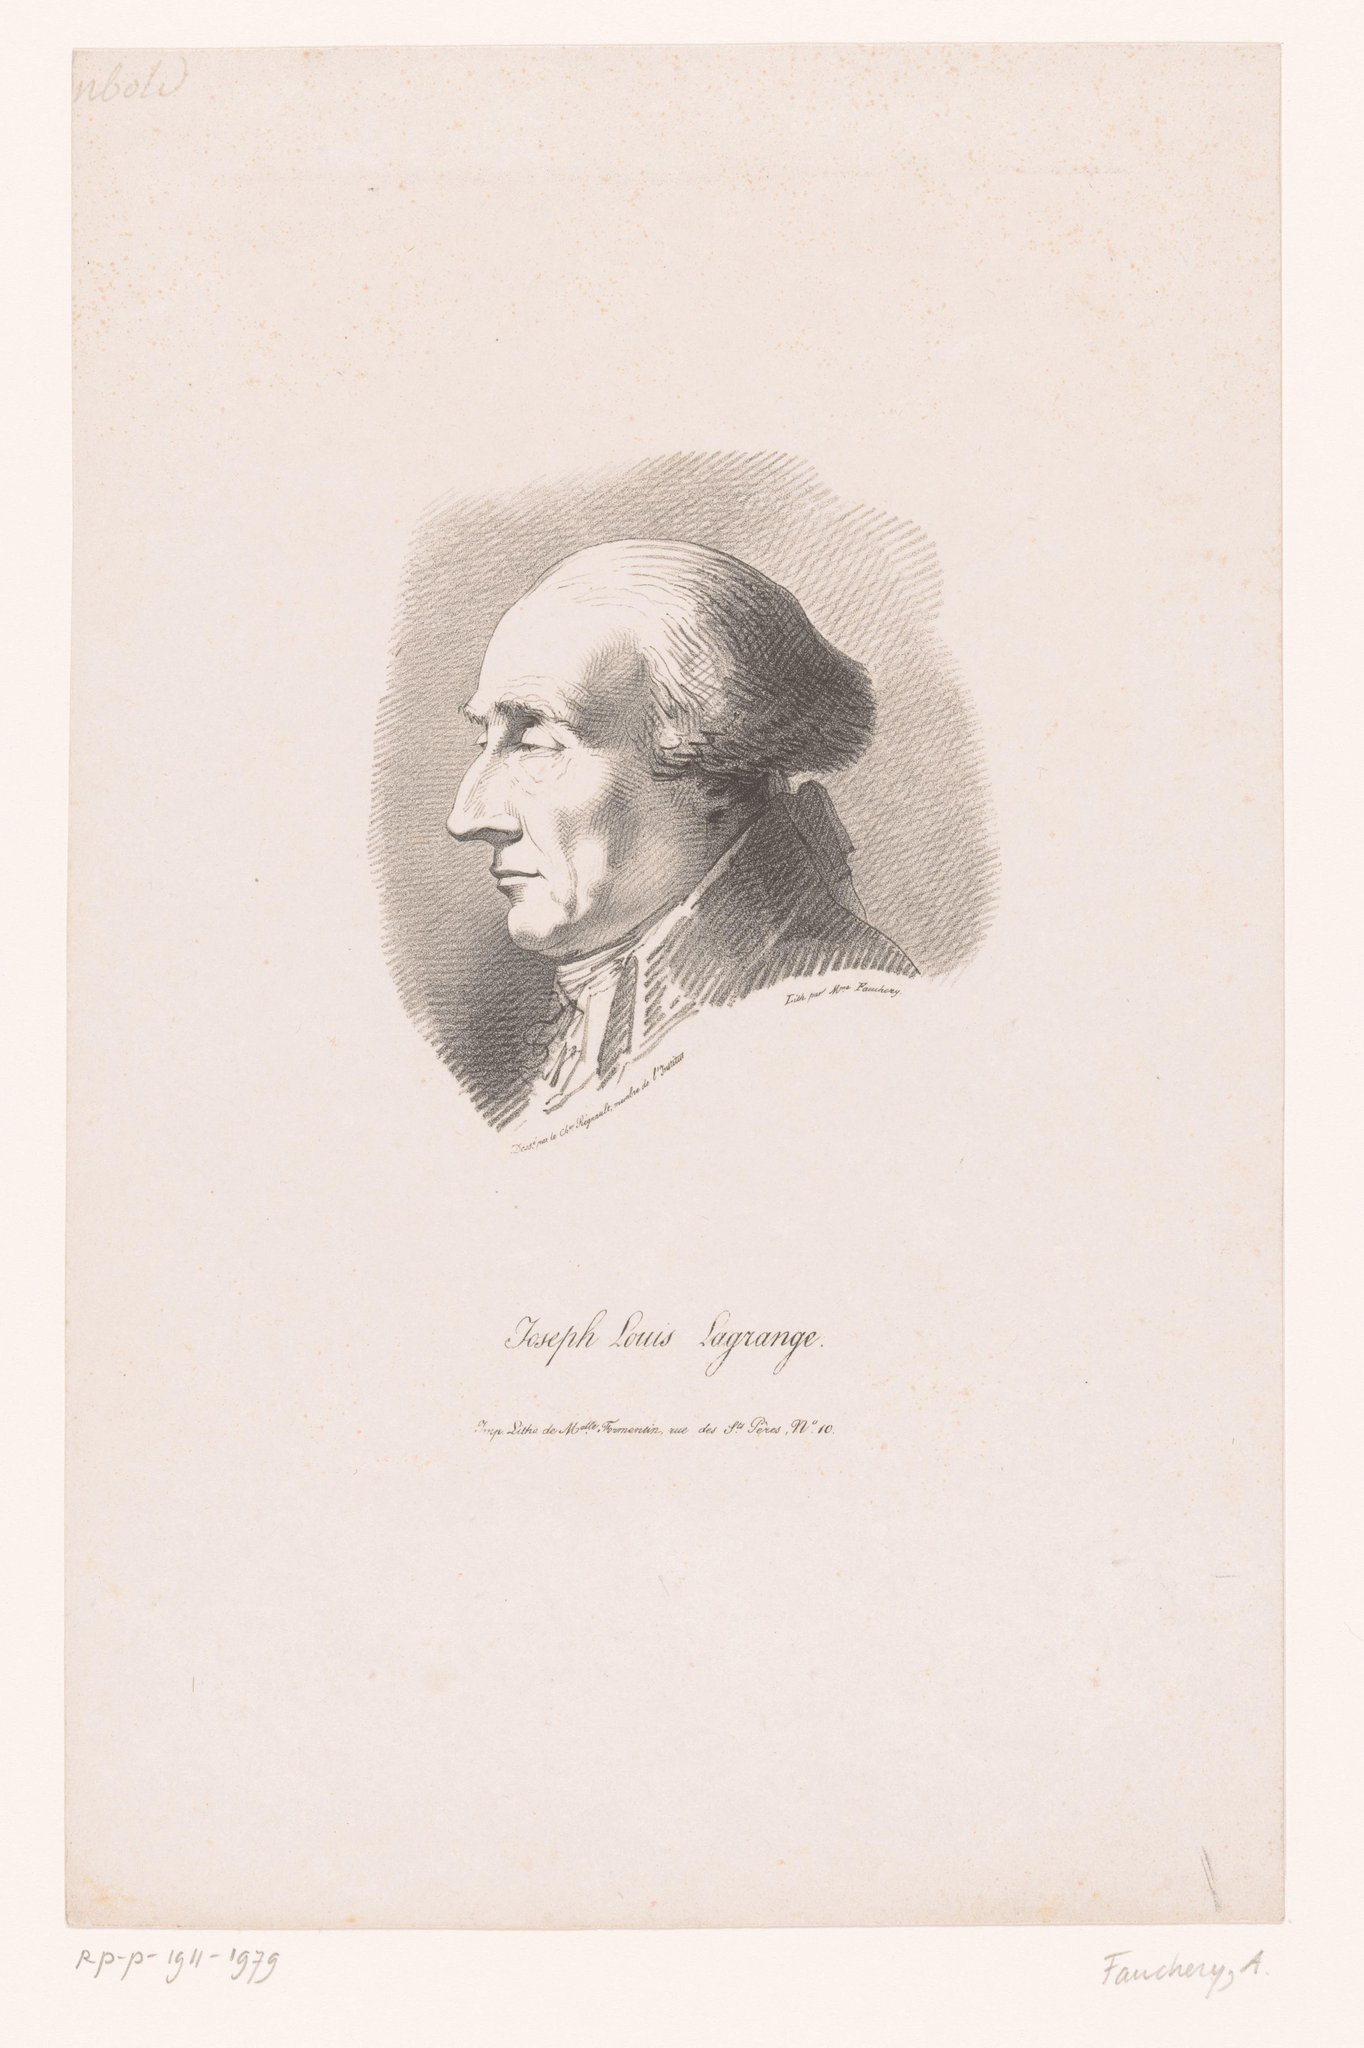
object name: print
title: Portret van Joseph-Louis Lagrange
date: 1842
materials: paper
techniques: lithograph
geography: paris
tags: paris, historical persons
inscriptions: collector's mark: Lugt 2228a